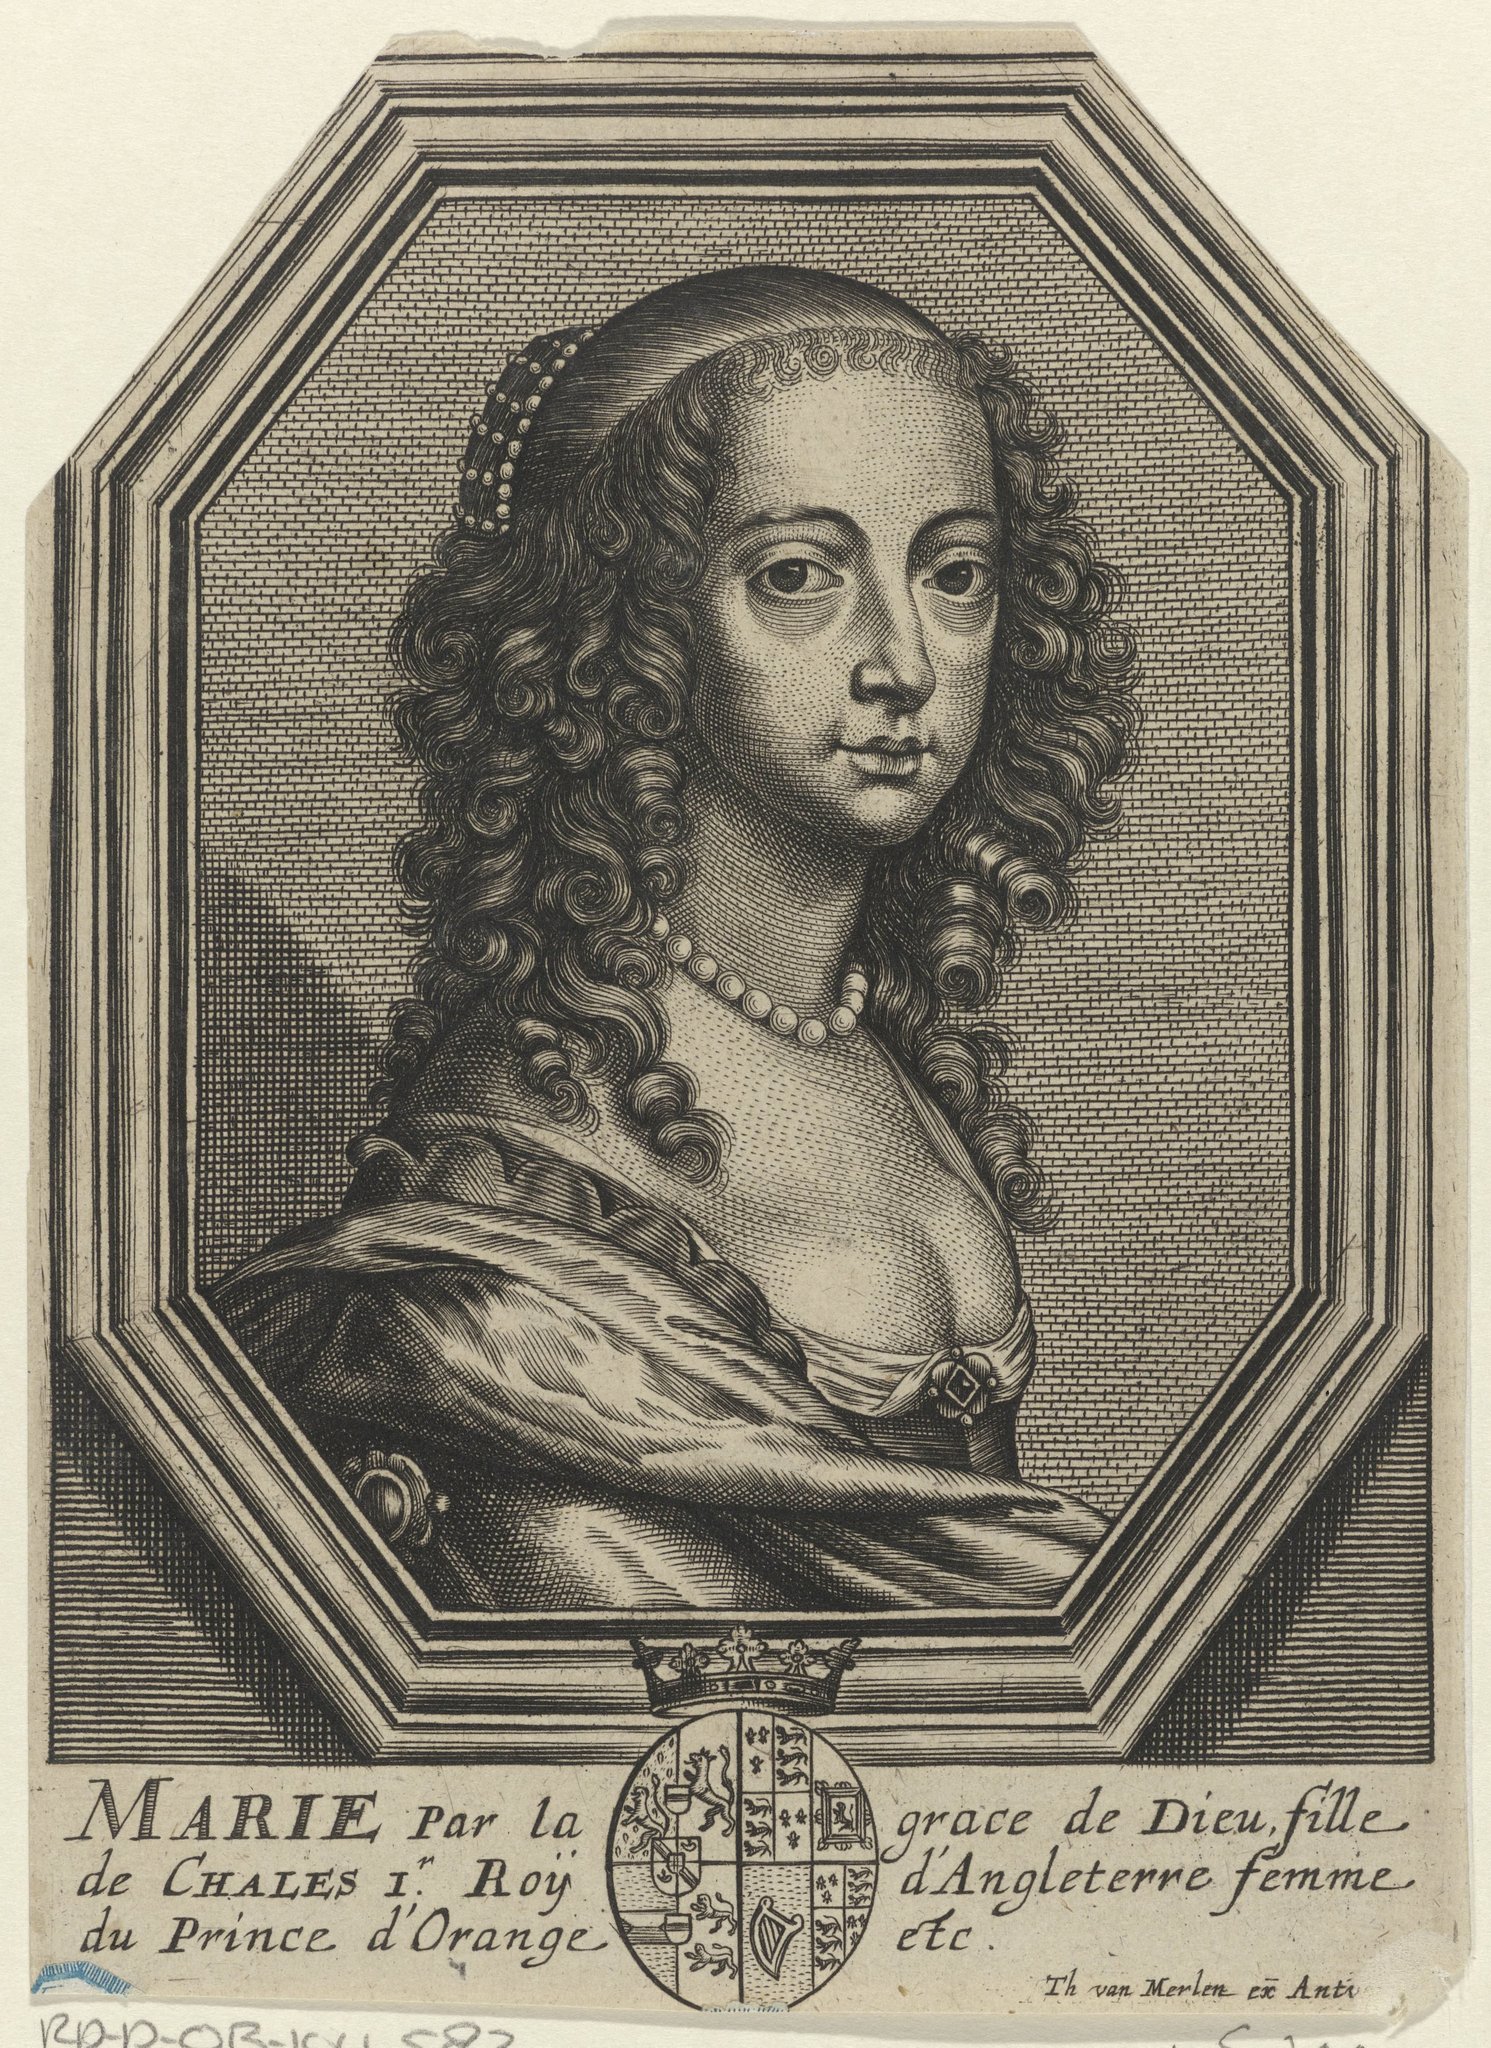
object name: print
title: Portret van Maria Henrietta Stuart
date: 1631-1672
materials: paper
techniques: engraving, etching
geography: low countries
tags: london, mary henrietta stuart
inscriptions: collector's mark: Lugt 2228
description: Portret van Maria Henrietta in een achtkantige omlijsting. Midden onder haar wapen. In de ondermarge drie regels Franse tekst.